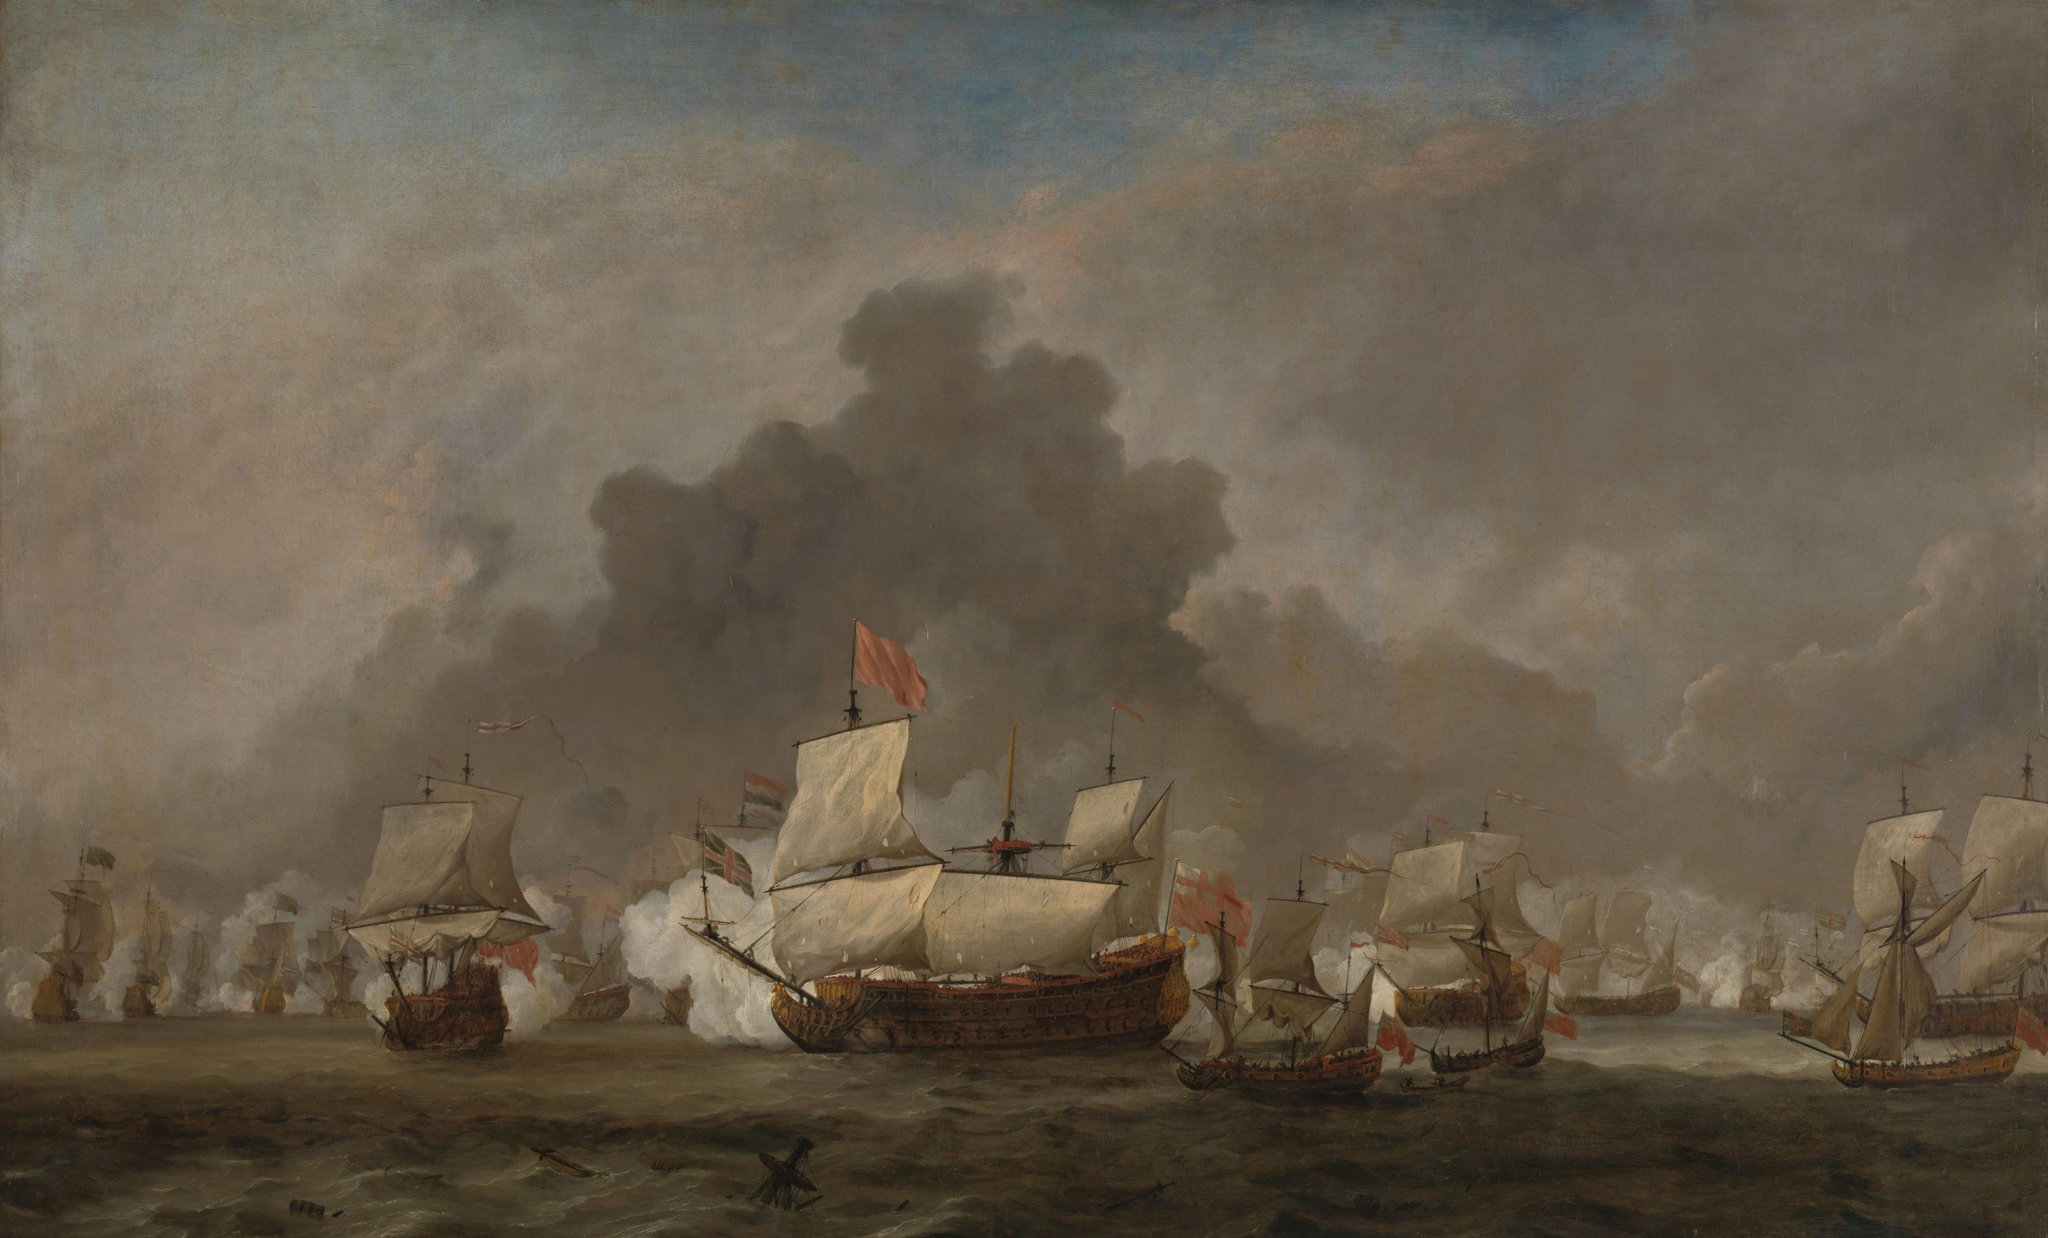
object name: painting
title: "Naval Battle between Michiel Adriaenszoon de Ruyter and the Duke of York on the ""Royal Prince"" during the Battle of Solebay, 7 June 1672: episode from the Third Anglo-Dutch War"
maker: willem van de velde (ii)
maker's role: draughtsman, painter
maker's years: 1633-1707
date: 1691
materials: canvas, oil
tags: flushing, michiel adriaenszoon de ruyter, sailing-ship, sailing-boat, battle (+ sailing-ships), battle of solebay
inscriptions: signature: ‘W. vand. Velde Int.’, signature and date: ‘W. v. Velde J. 1691’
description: Het gevecht van Michiel Adriaenszoon de Ruyter tegen de hertog van York op de 'Royal Prince' tijdens de zeeslag bij Solebay, 7 juni 1672: episode uit de Derde Engelse Zeeoorlog (1672-74). In het midden vaart het Engelse schip, zonder het bovendeel van de mast. Rond dit schip zeilen enkele kleine schepen.